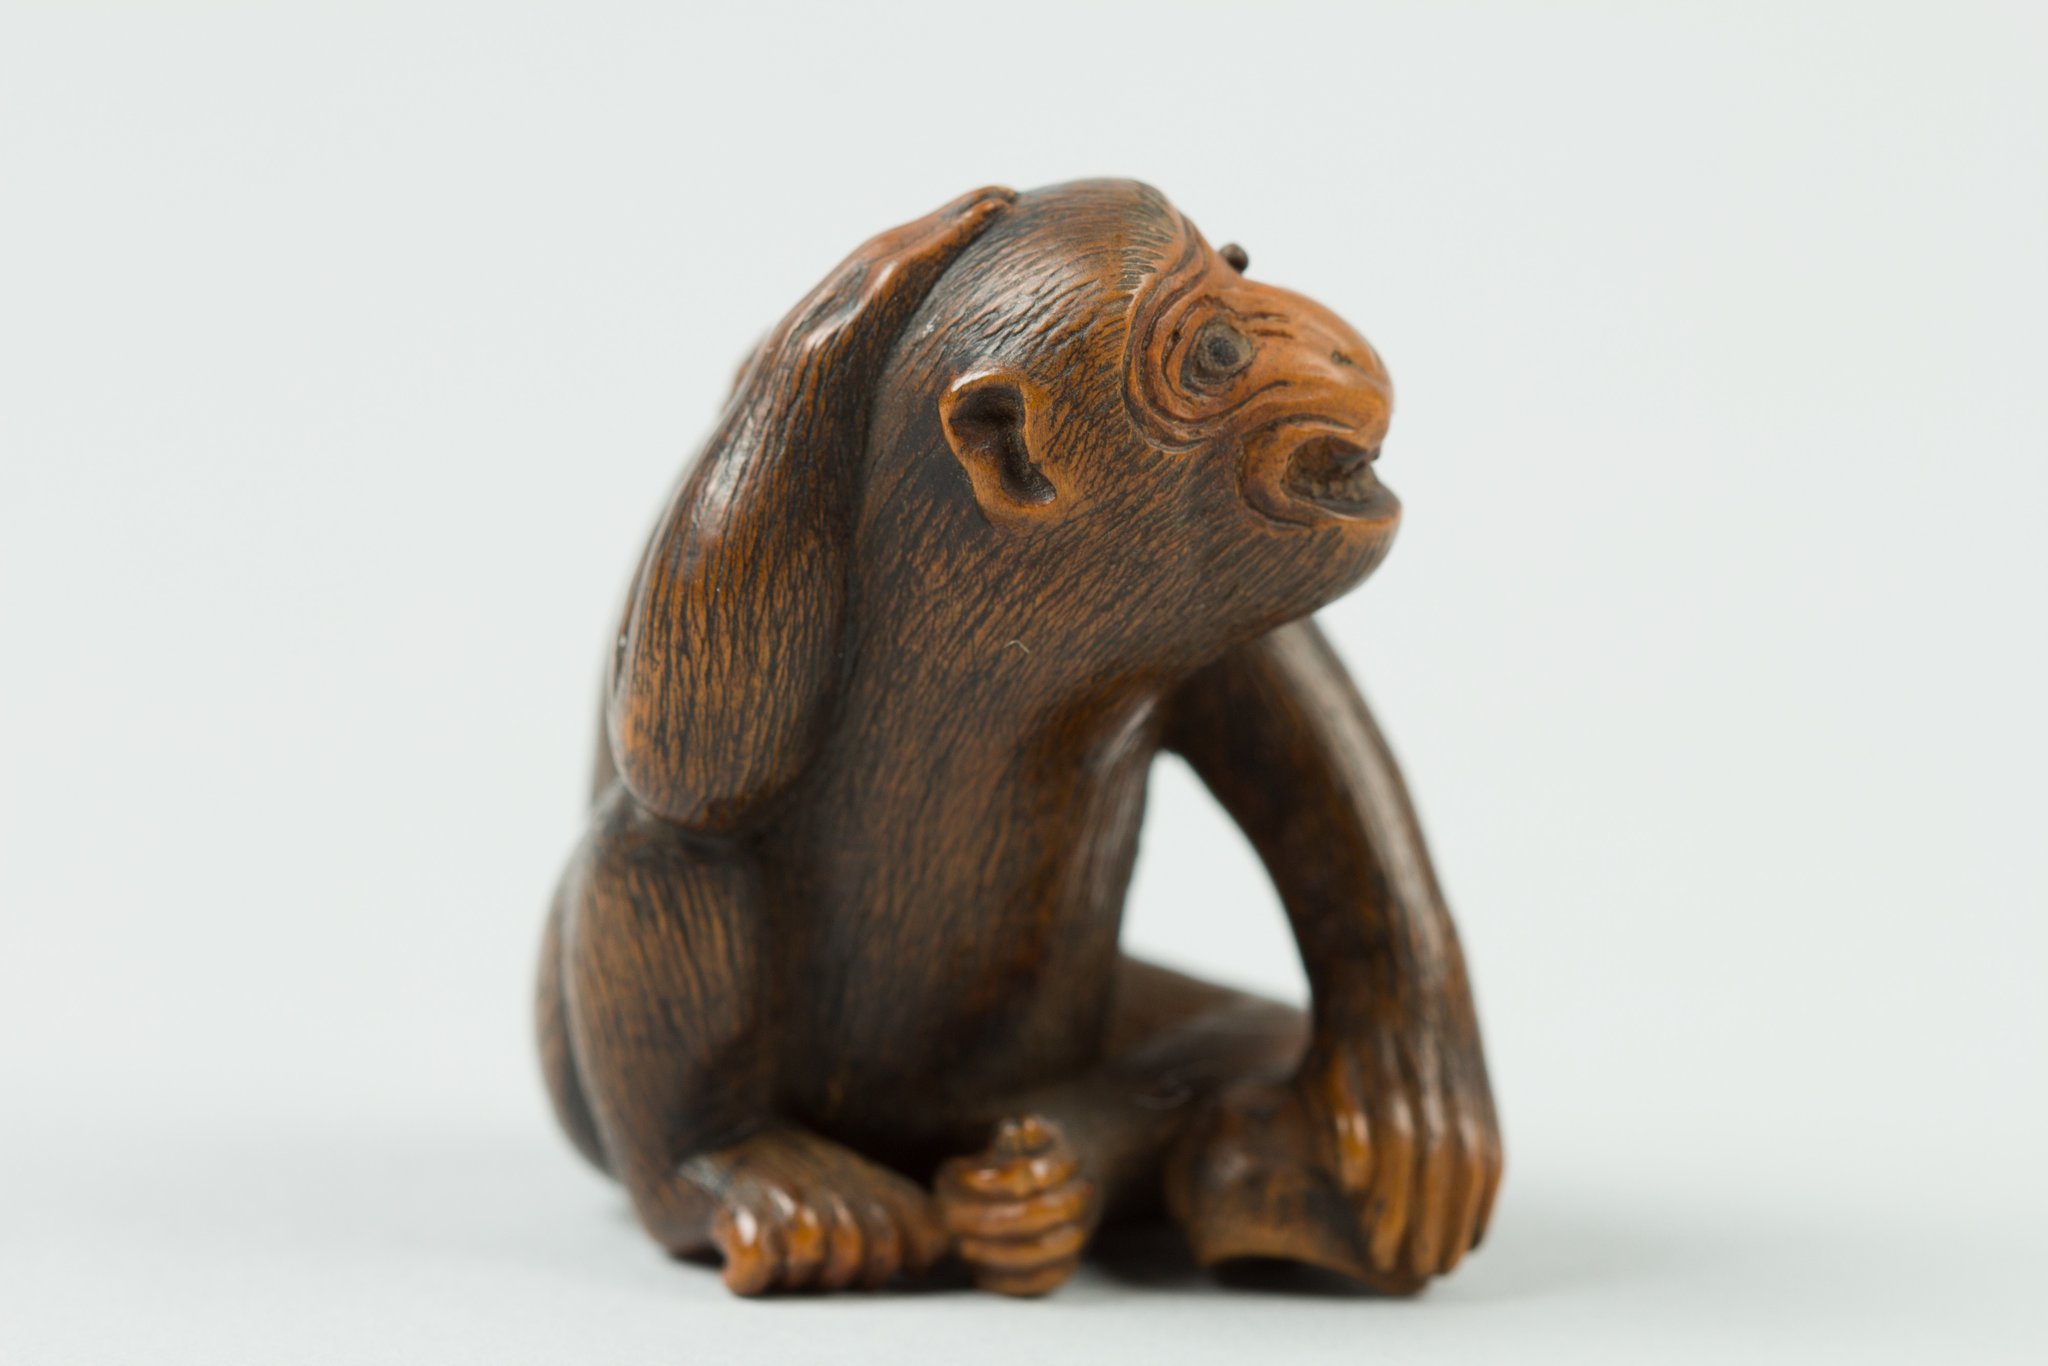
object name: netsuke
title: Netsuke of Monkey with a Bee on His Back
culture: japanese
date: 1801-1900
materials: wood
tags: bees,monkeys